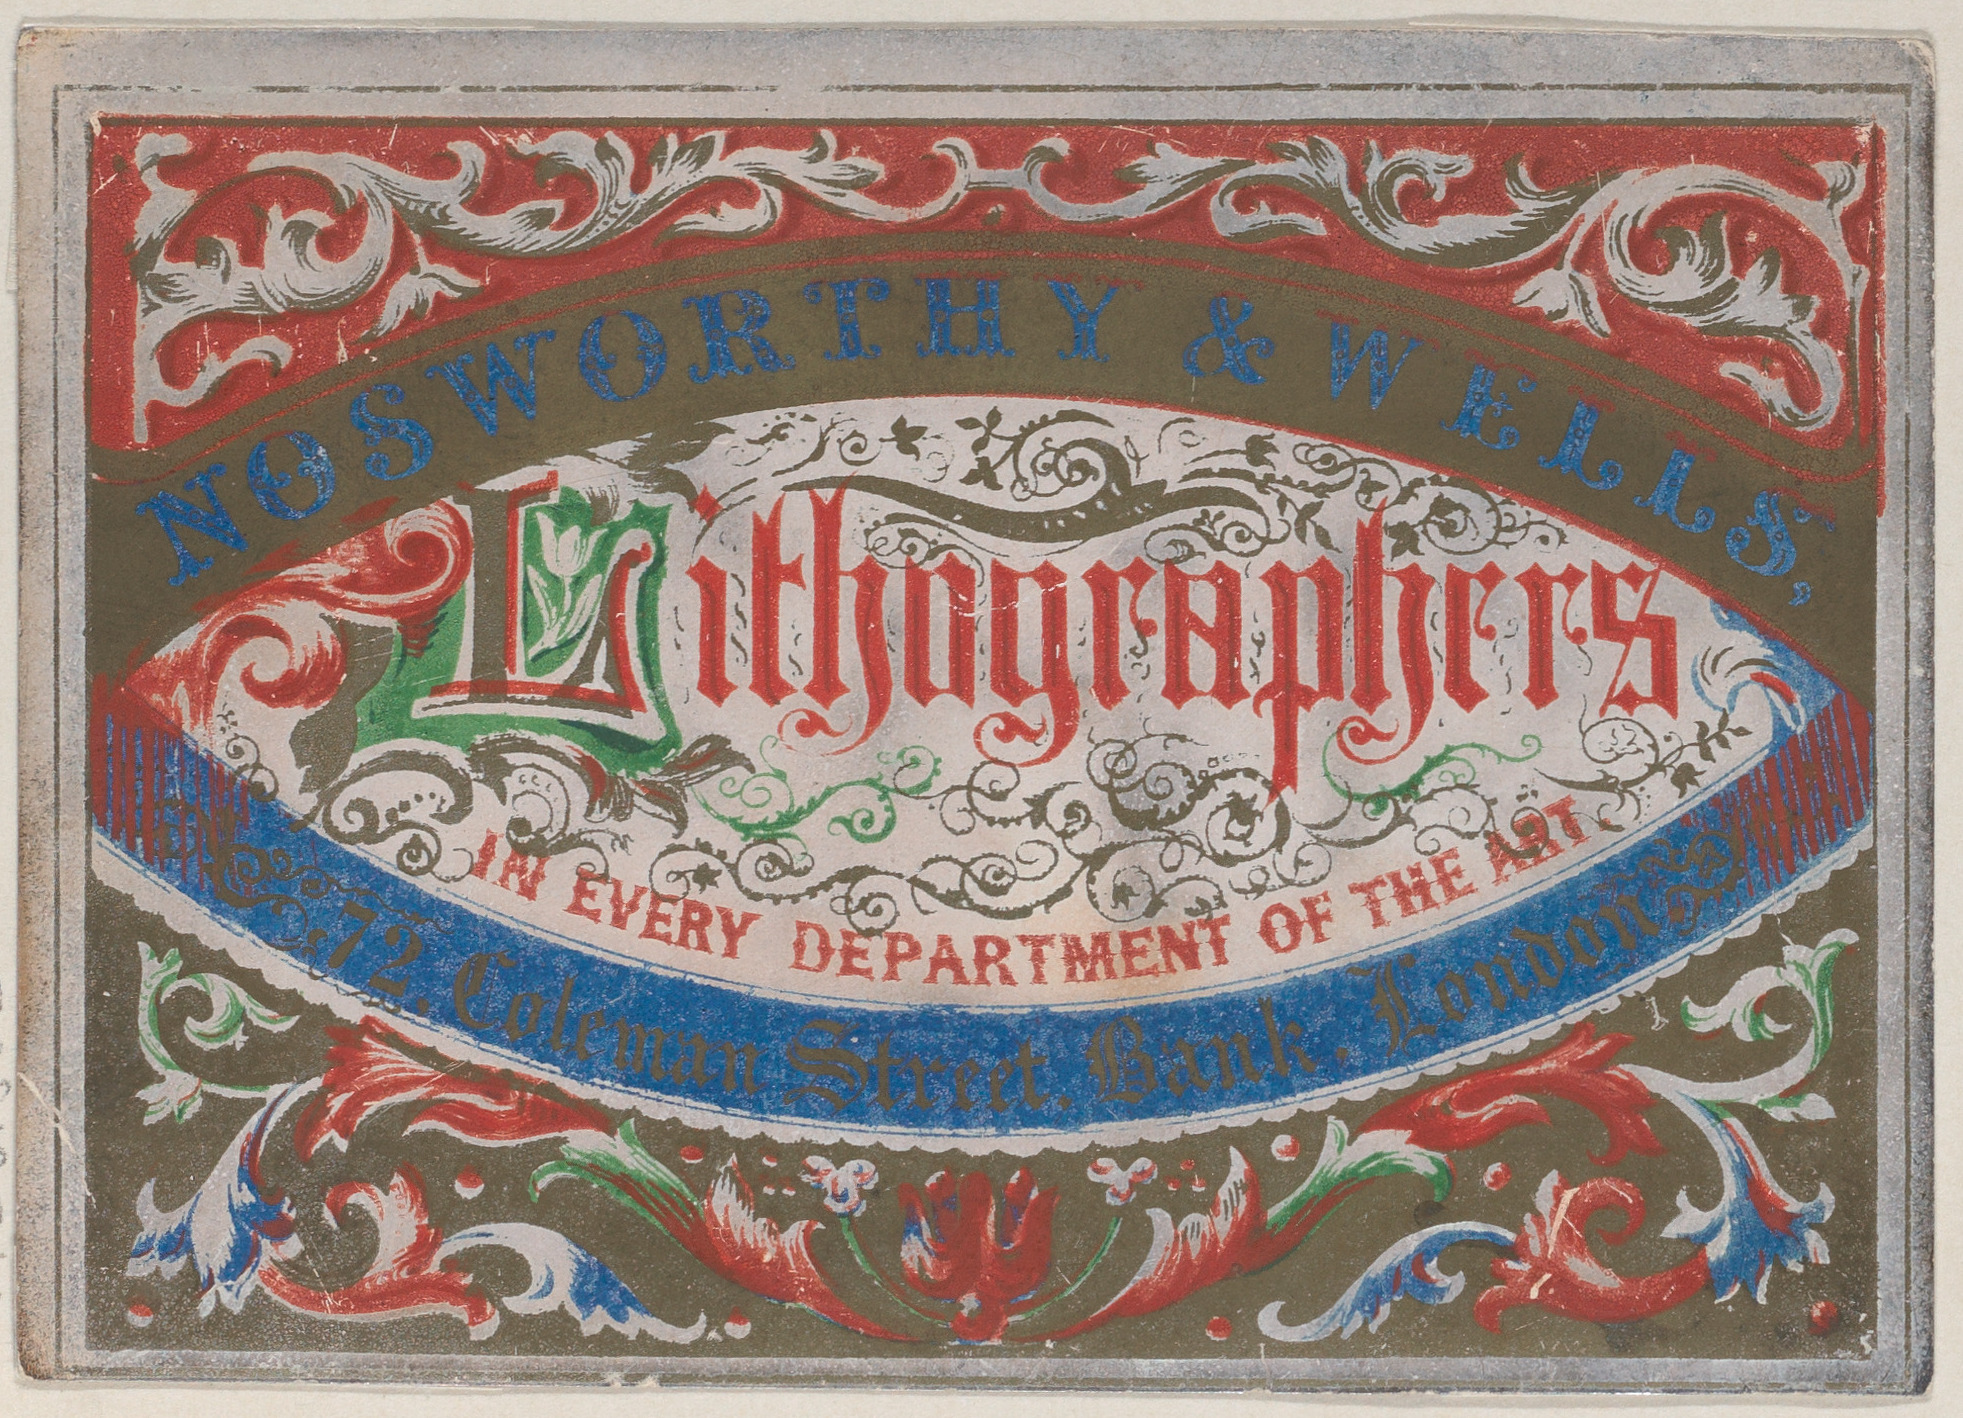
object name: print, trade card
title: Trade Card for Nosworthy & Wells, Lithographers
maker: anonymous, british, 19th century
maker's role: artist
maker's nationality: british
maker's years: 1800-1900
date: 1801-1900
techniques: lithograph